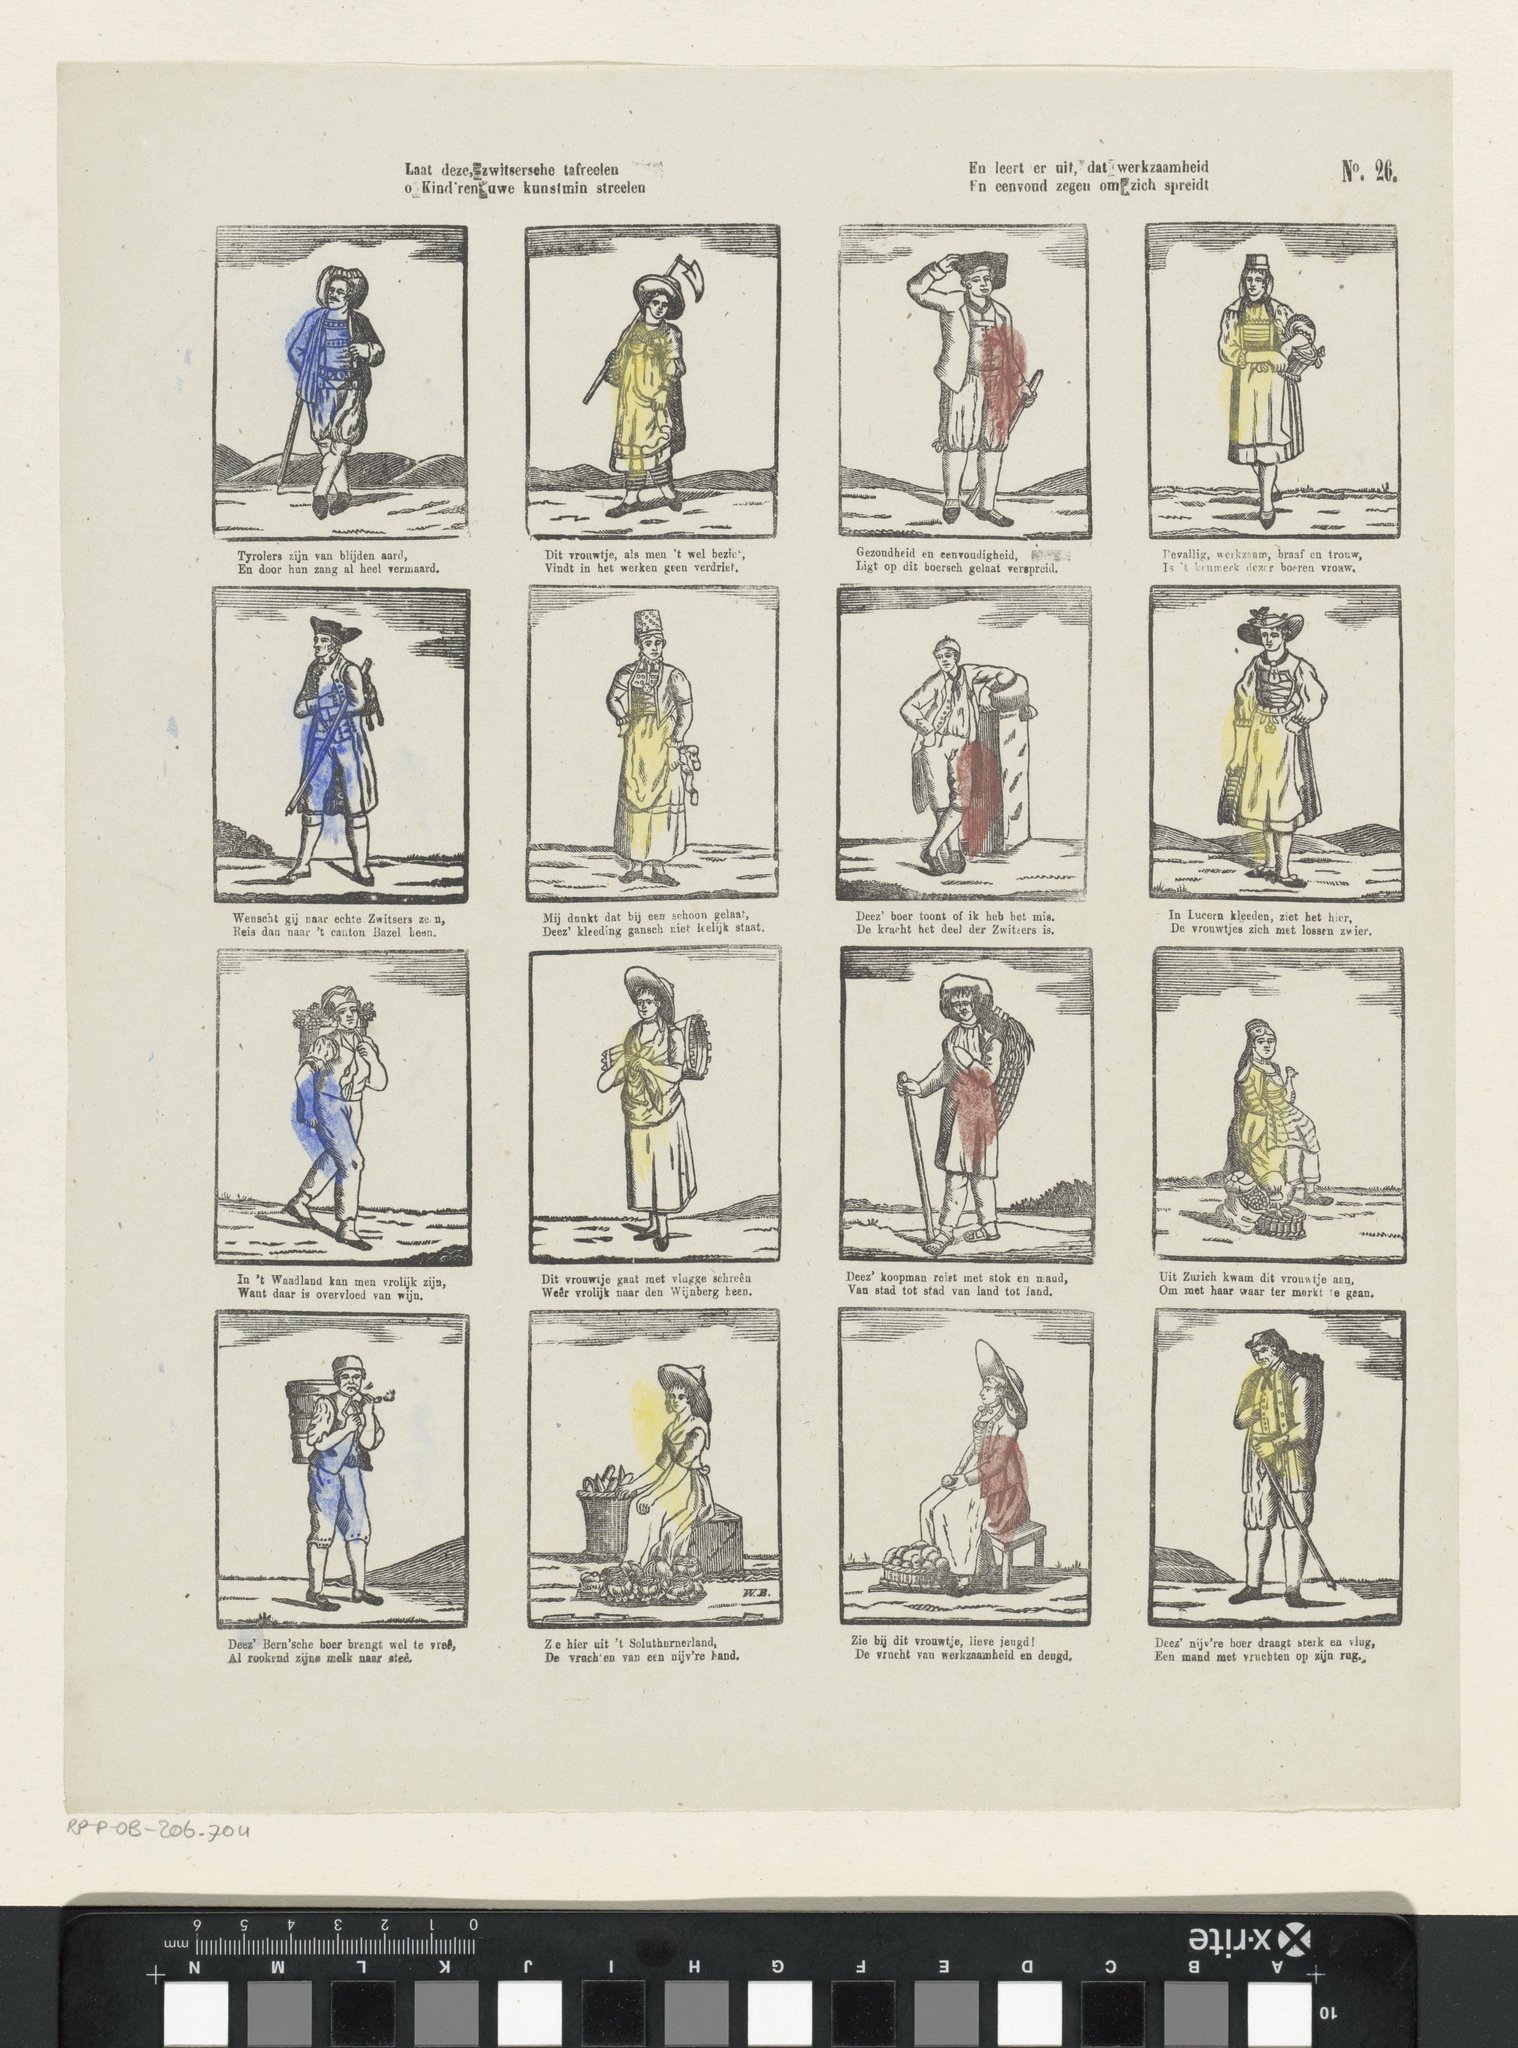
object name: popular print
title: Laat deze, Zwitsersche tafreelen, / O kind'ren, uwen kunstmin streelen, / En leert er uit, dat werkzaamheid, / En eenvoud zegen om zich spreidt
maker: willem bal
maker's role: print maker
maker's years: 1808-1897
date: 1850-1870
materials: paper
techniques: colour, letterpress printing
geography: netherlands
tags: europeans (with name), human types, characters (human types), switzerland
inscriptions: collector's mark: Lugt 2760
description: Blad met 16 voorstellingen van verschillende mensen uit Zwitserland. Onder elke voorstelling een tweeregelig vers. Rechtsboven genummerd: No. 26.